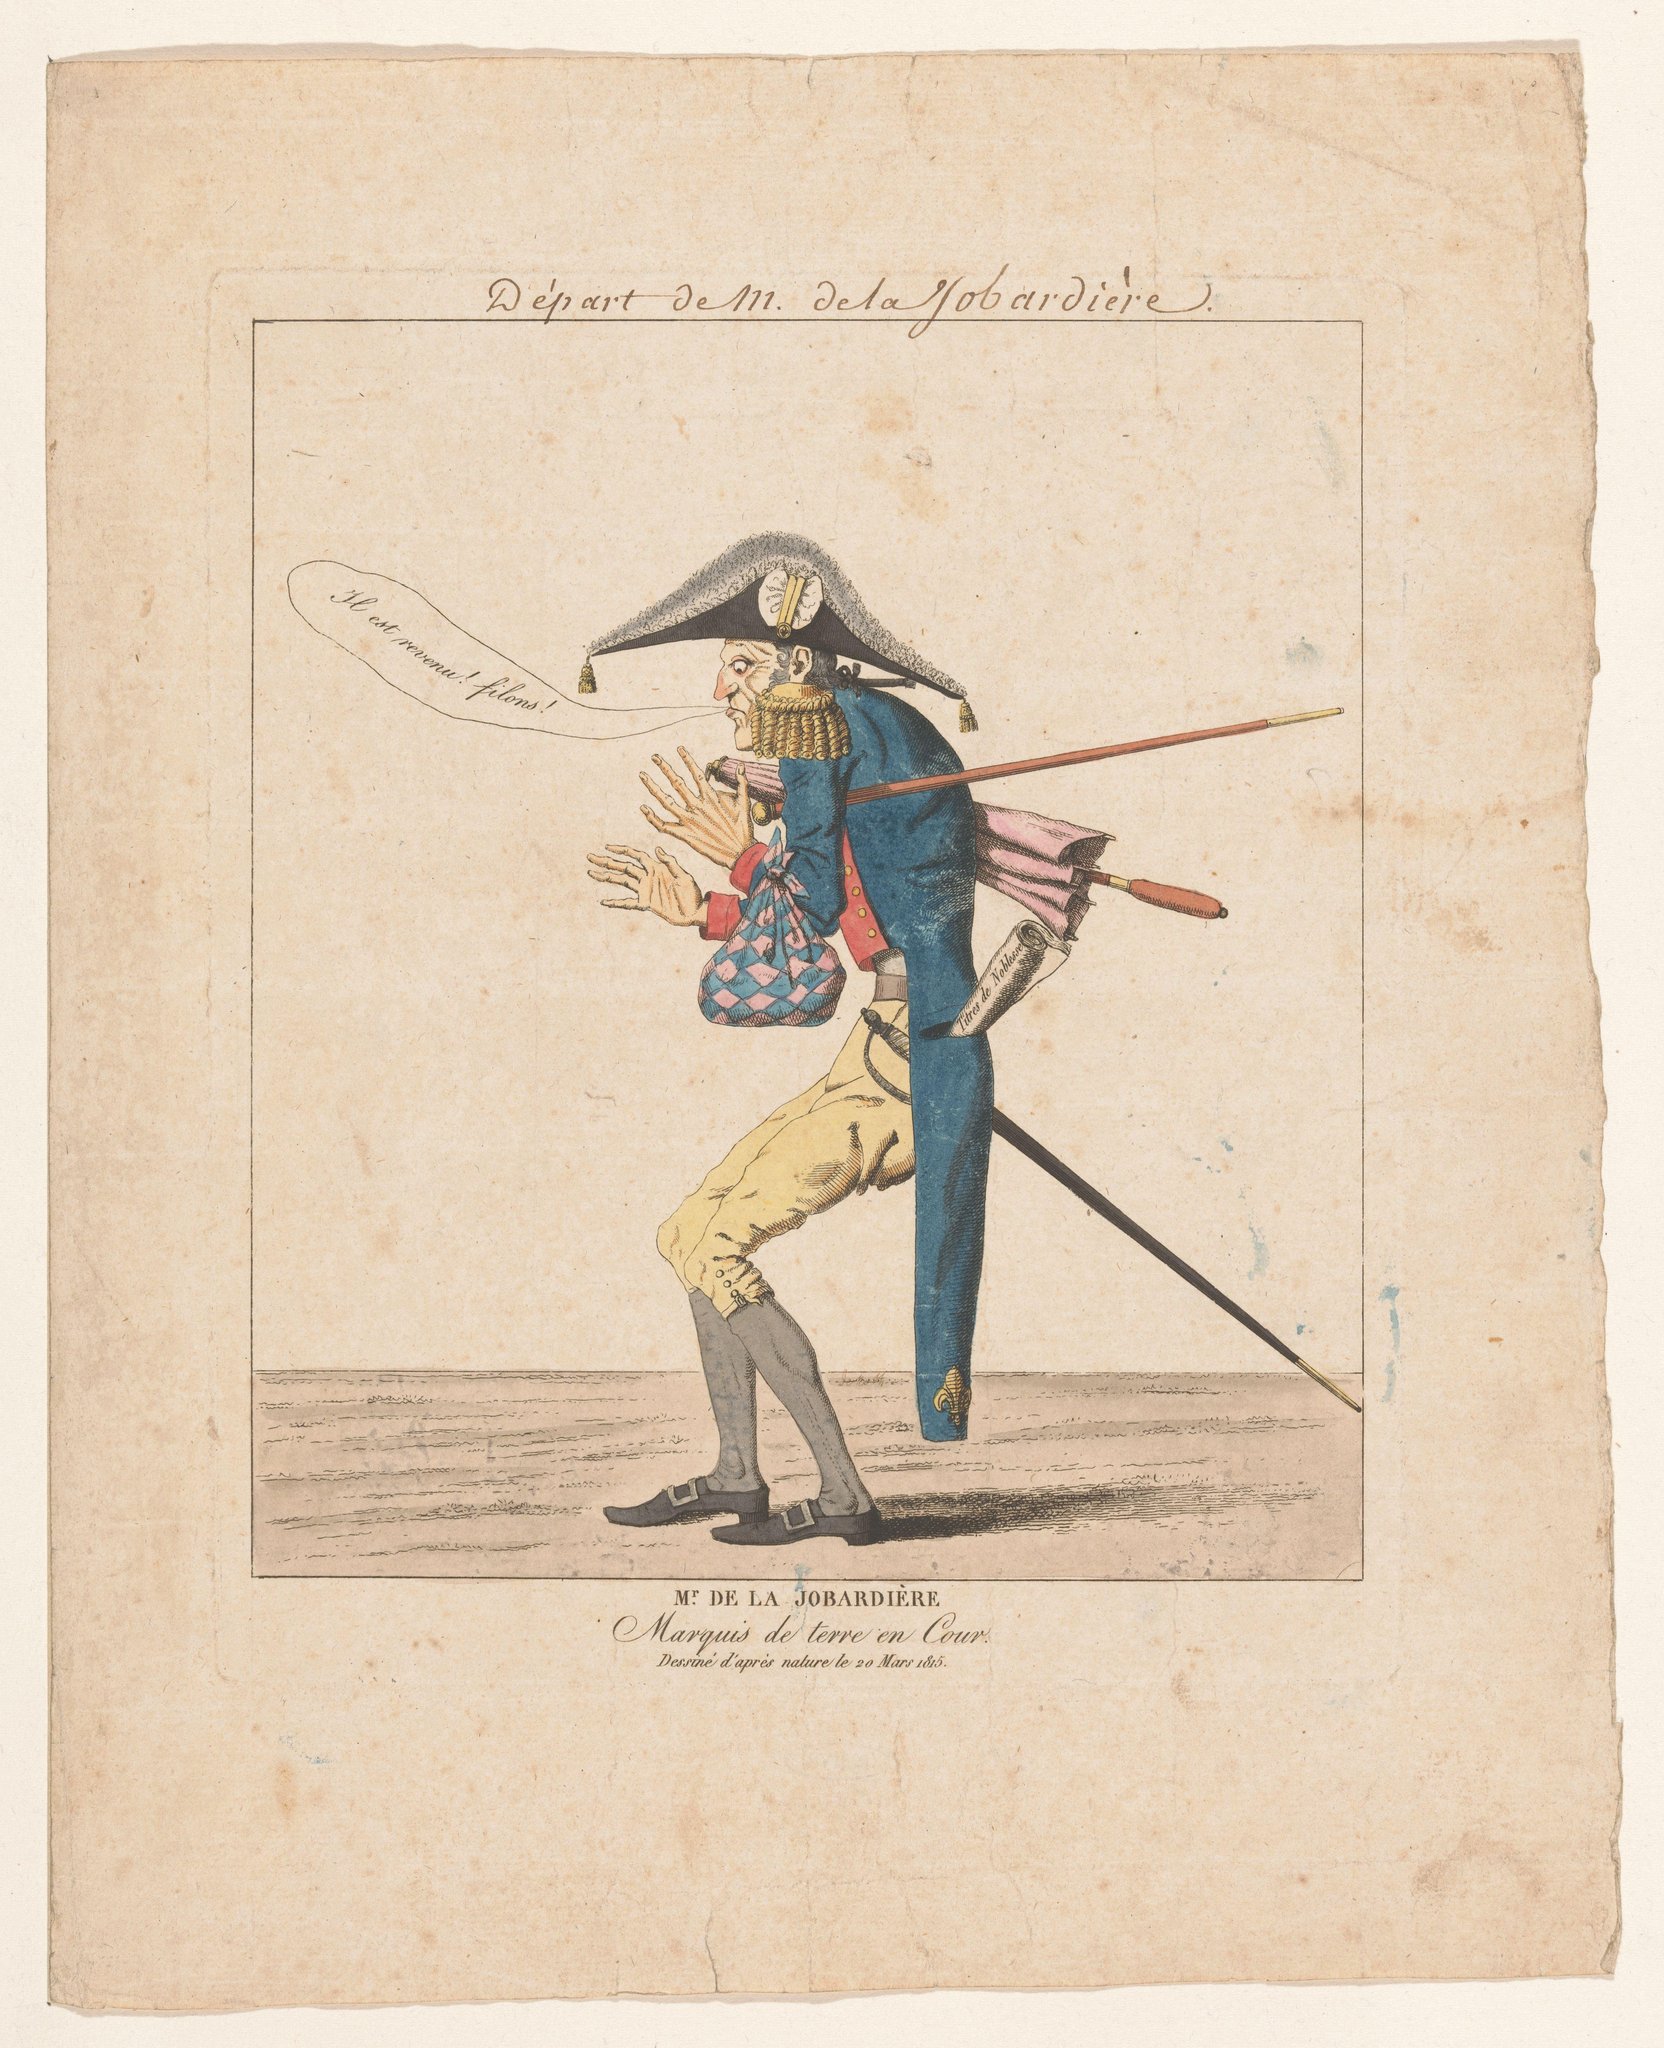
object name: cartoon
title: Karikatuur van de markies De la Jobardière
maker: Anonymous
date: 1815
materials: paper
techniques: etching, hand coloring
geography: france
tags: political caricatures and satires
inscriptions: collector's mark: Lugt 2228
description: Karikatuur van de literaire personage 'de markies De la Jobardière', bij zijn terugkeer naar Parijs, 20 maart 1815. Magere voorover gebogen figuur, paraplu onder de arm.